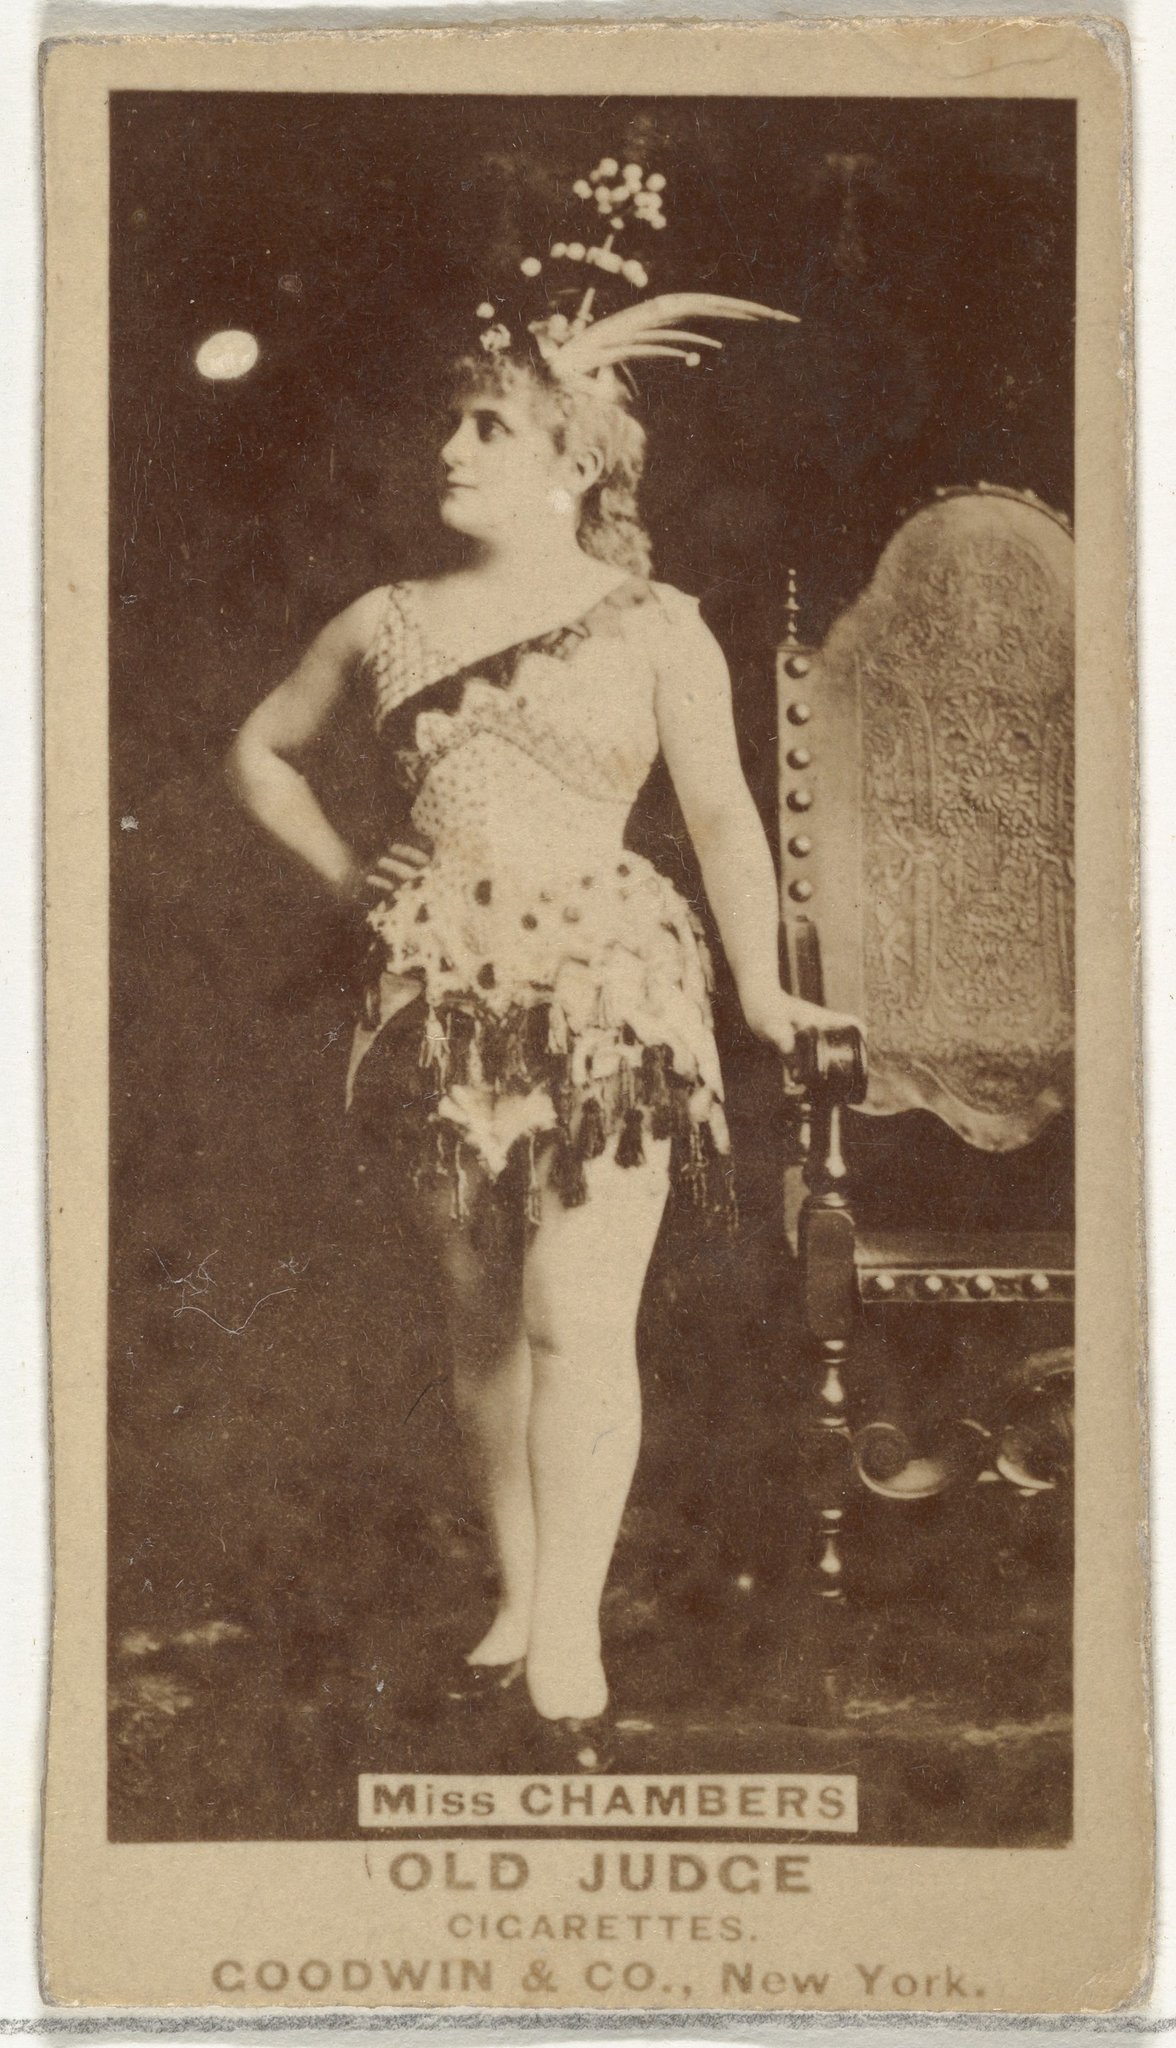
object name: photograph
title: Miss Chambers, from the Actors and Actresses series (N171) for Old Judge Cigarettes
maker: goodwin & company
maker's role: publisher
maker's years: 1850-1950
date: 1886-1890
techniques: albumen silver print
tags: portraits,women,actresses